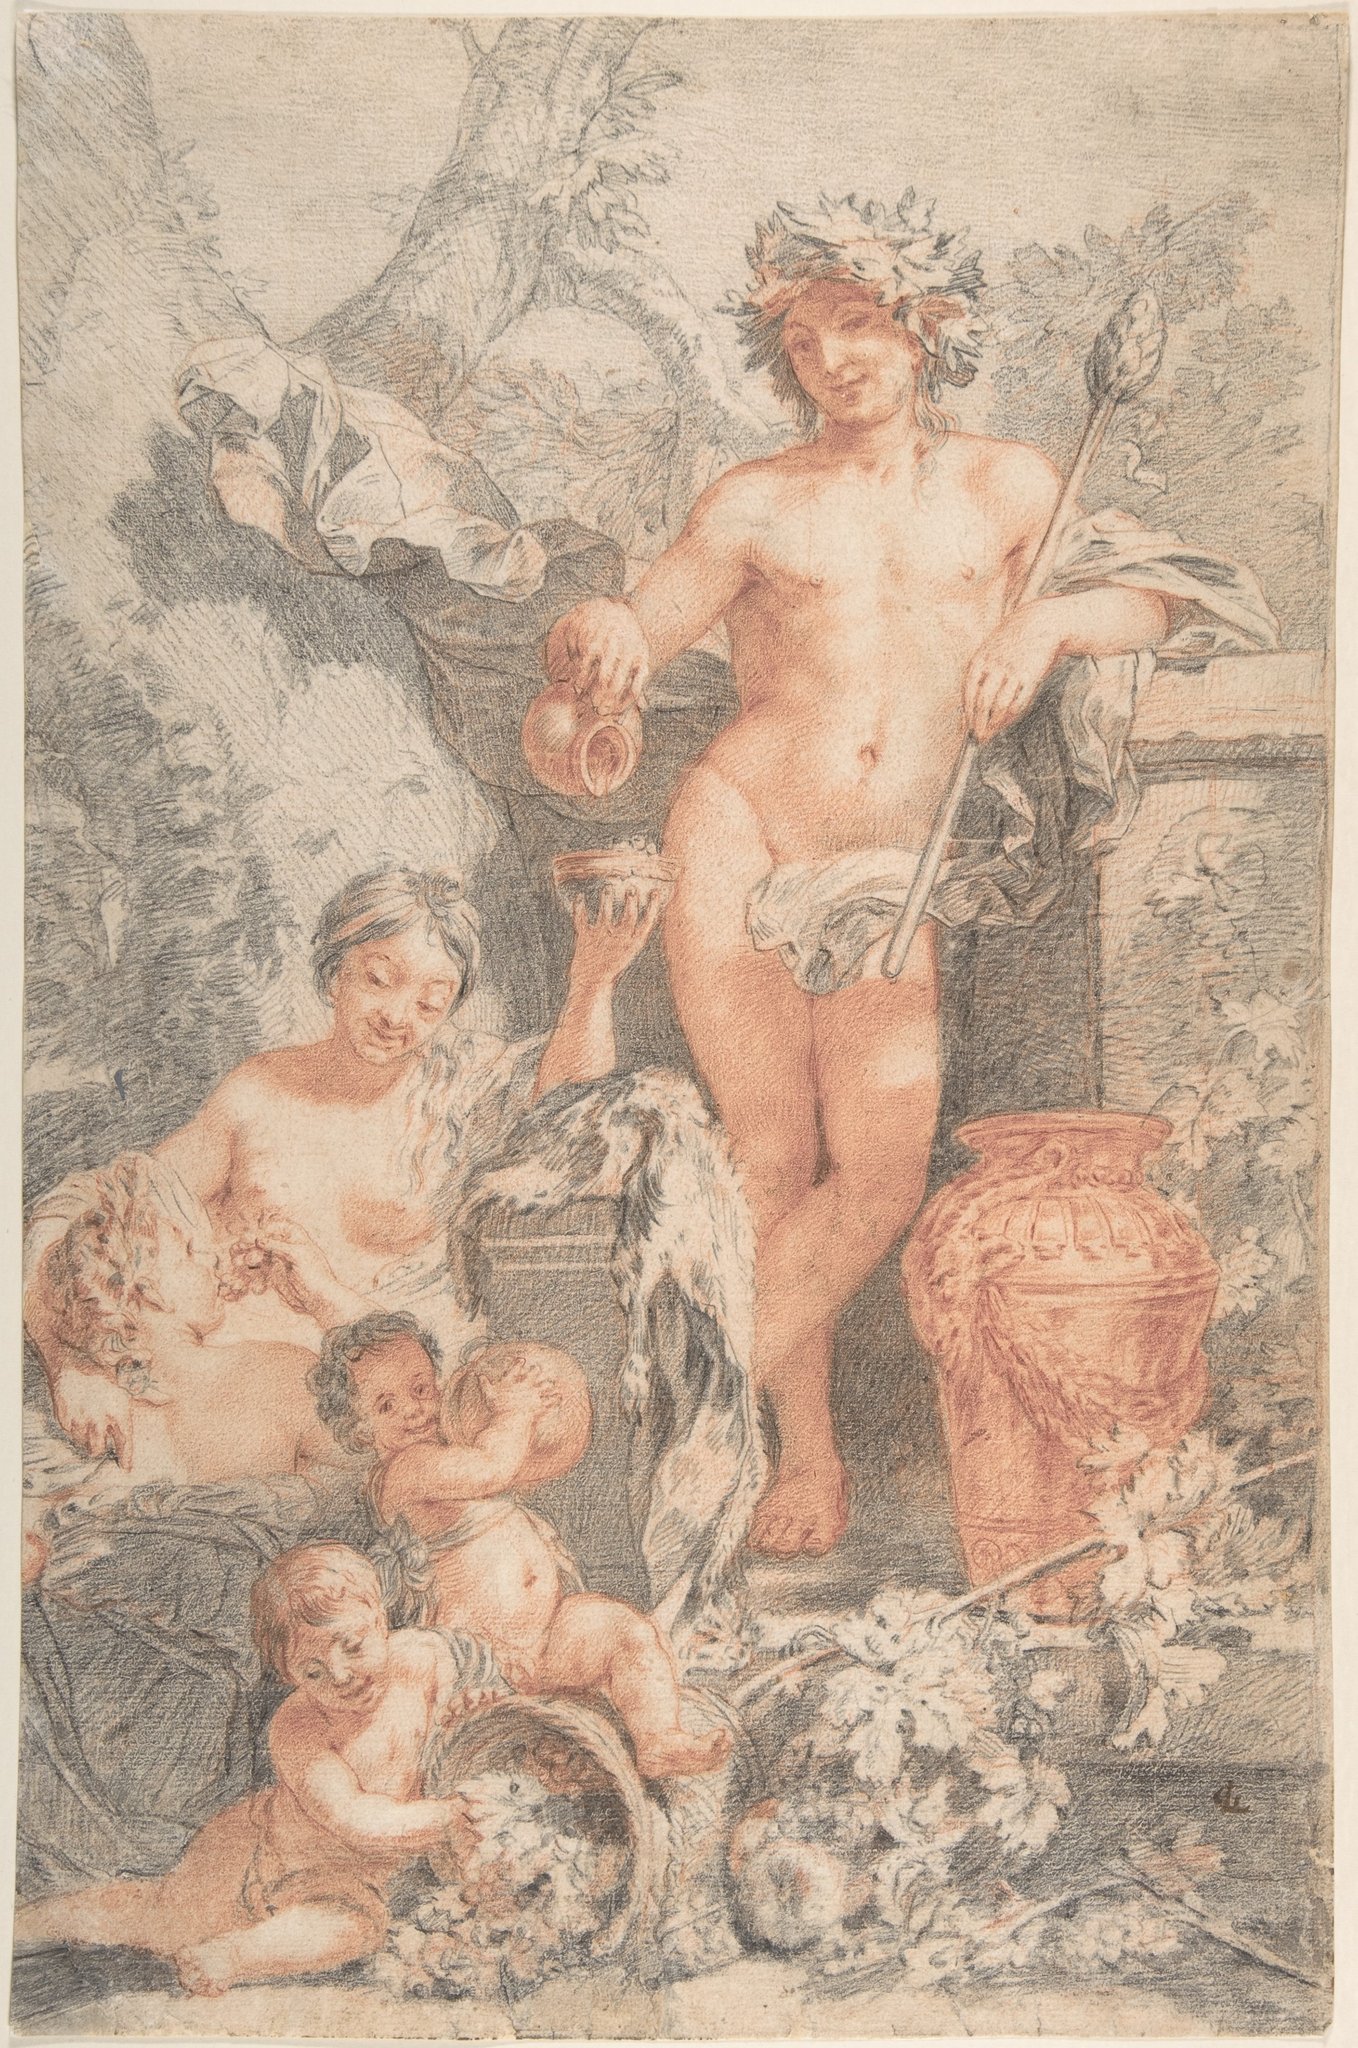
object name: drawing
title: Arcadian Scene with Bacchus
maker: gerard de lairesse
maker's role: artist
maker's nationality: dutch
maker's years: 1641-1711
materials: chalk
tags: children,male nudes,female nudes,bacchus